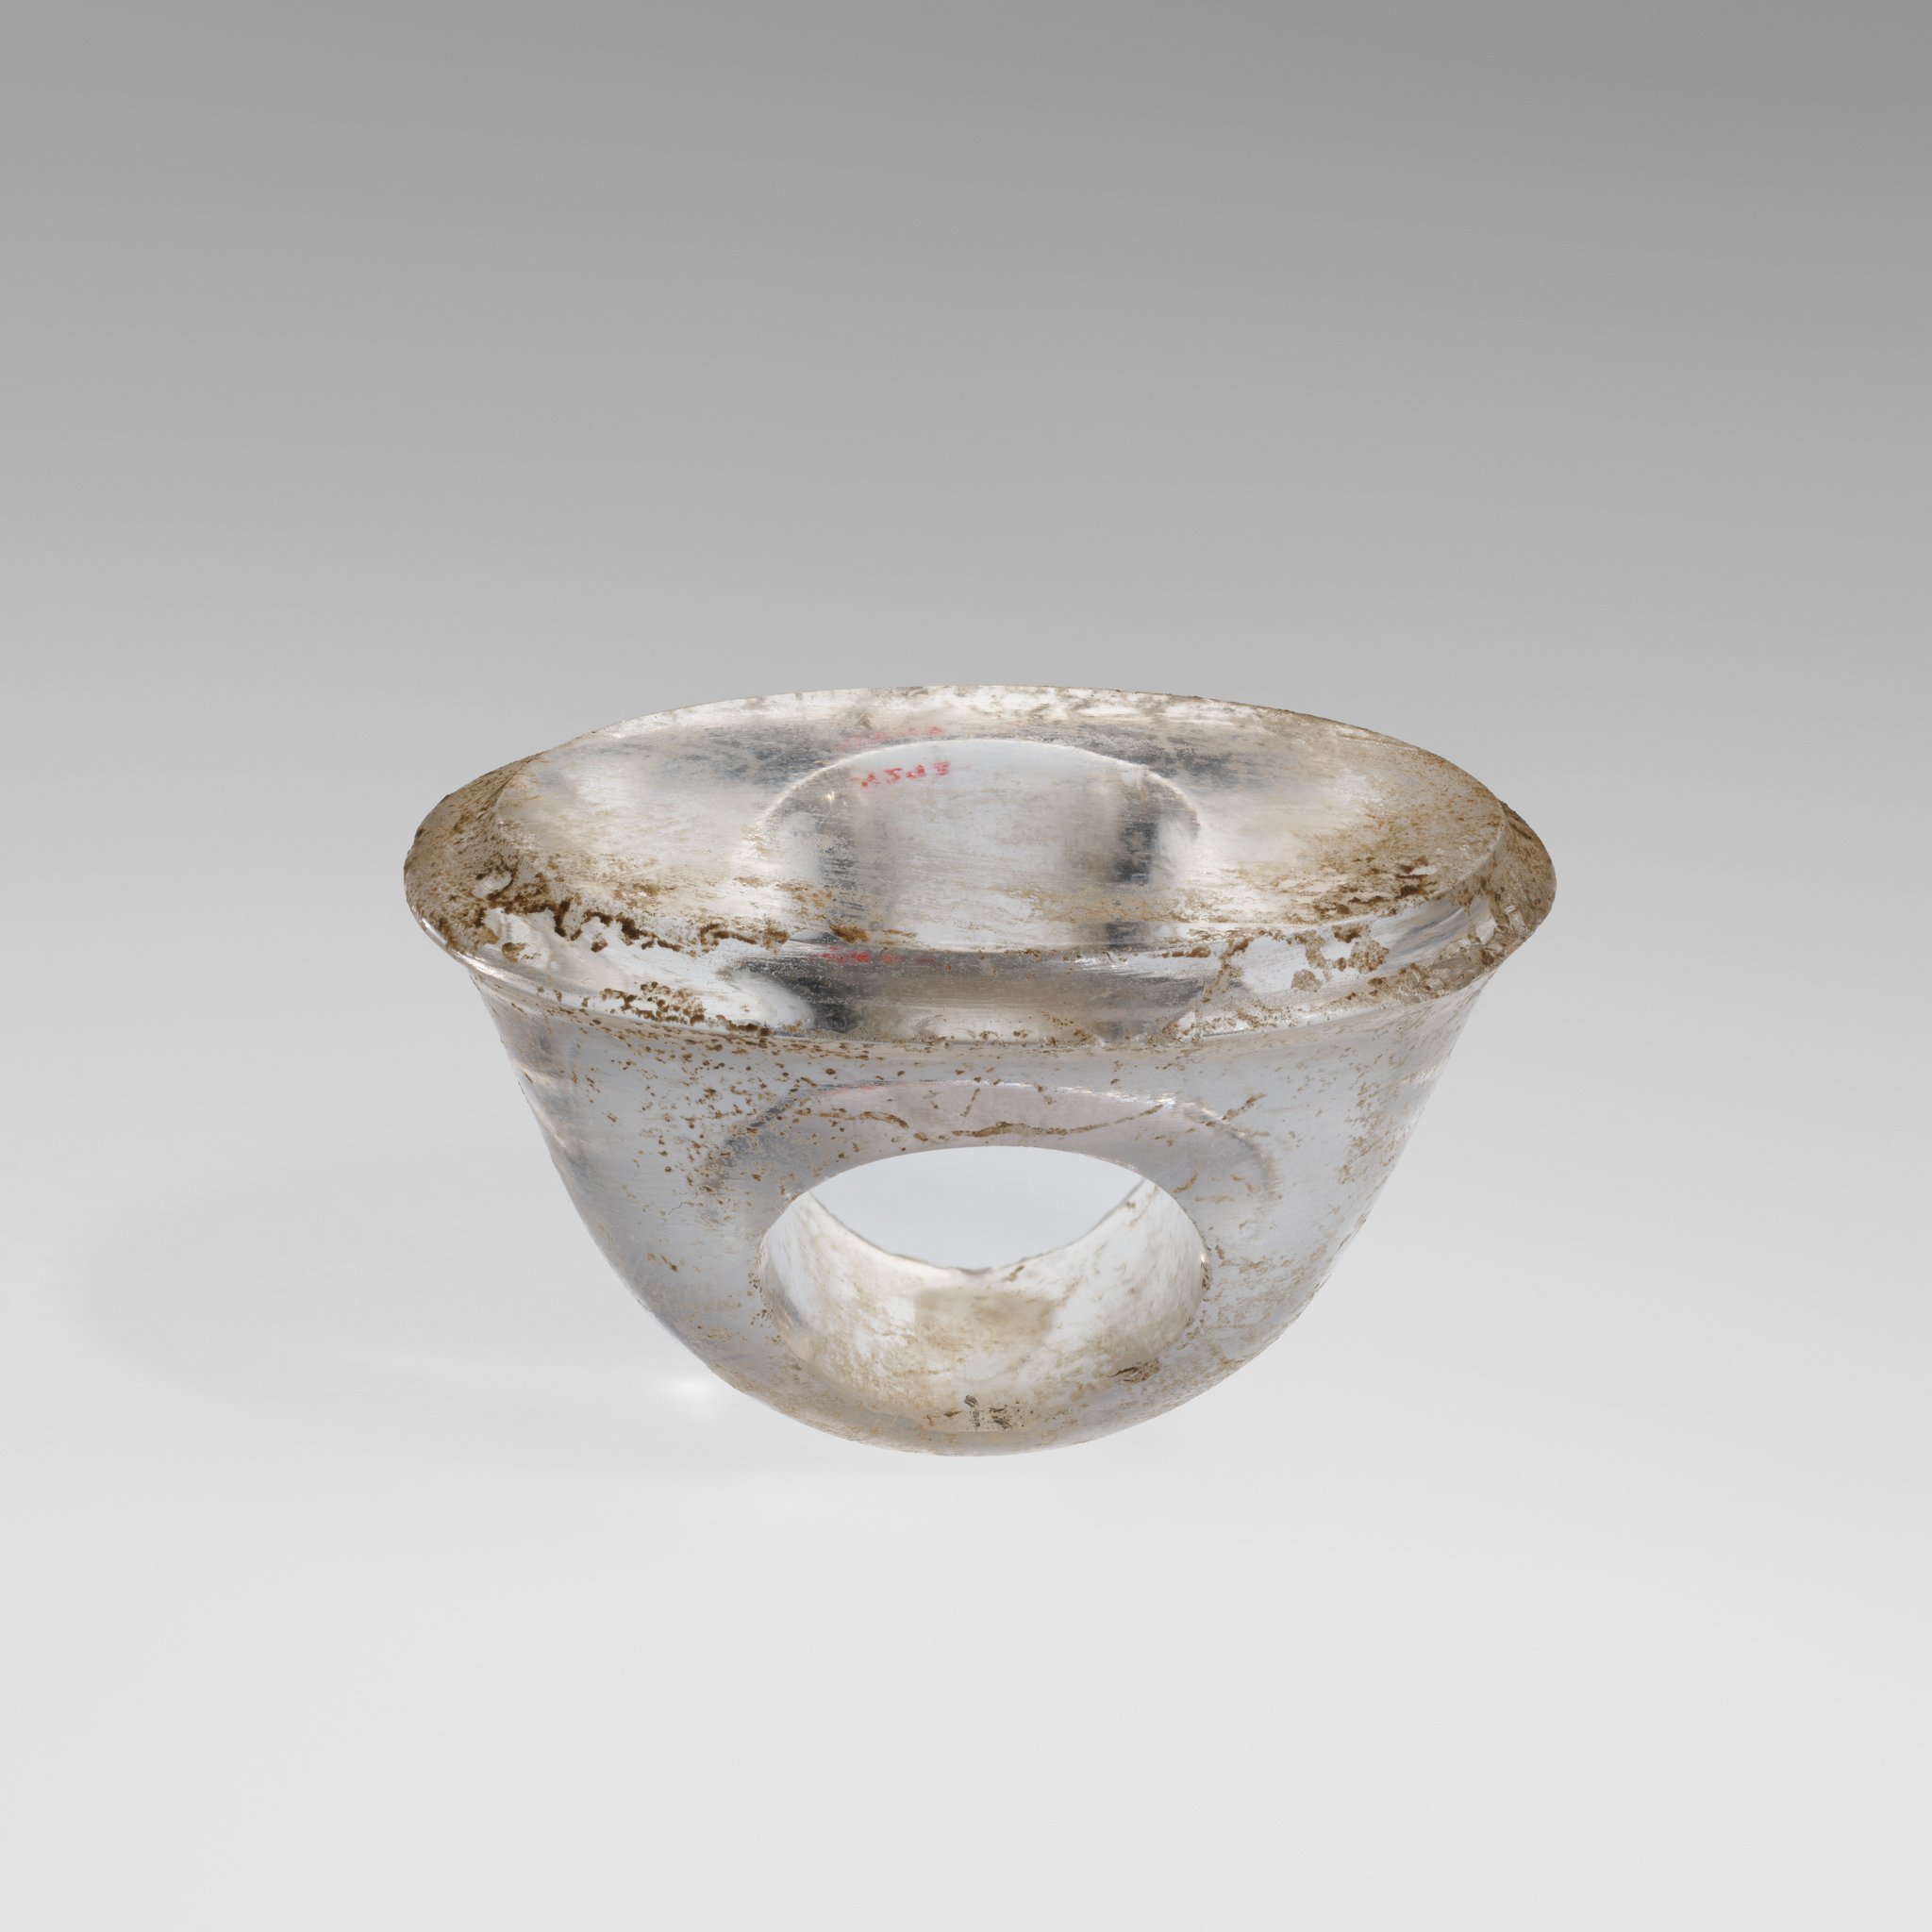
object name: ring of rock crystal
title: Rock crystal ring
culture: greek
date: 200-1 BCE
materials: quartz